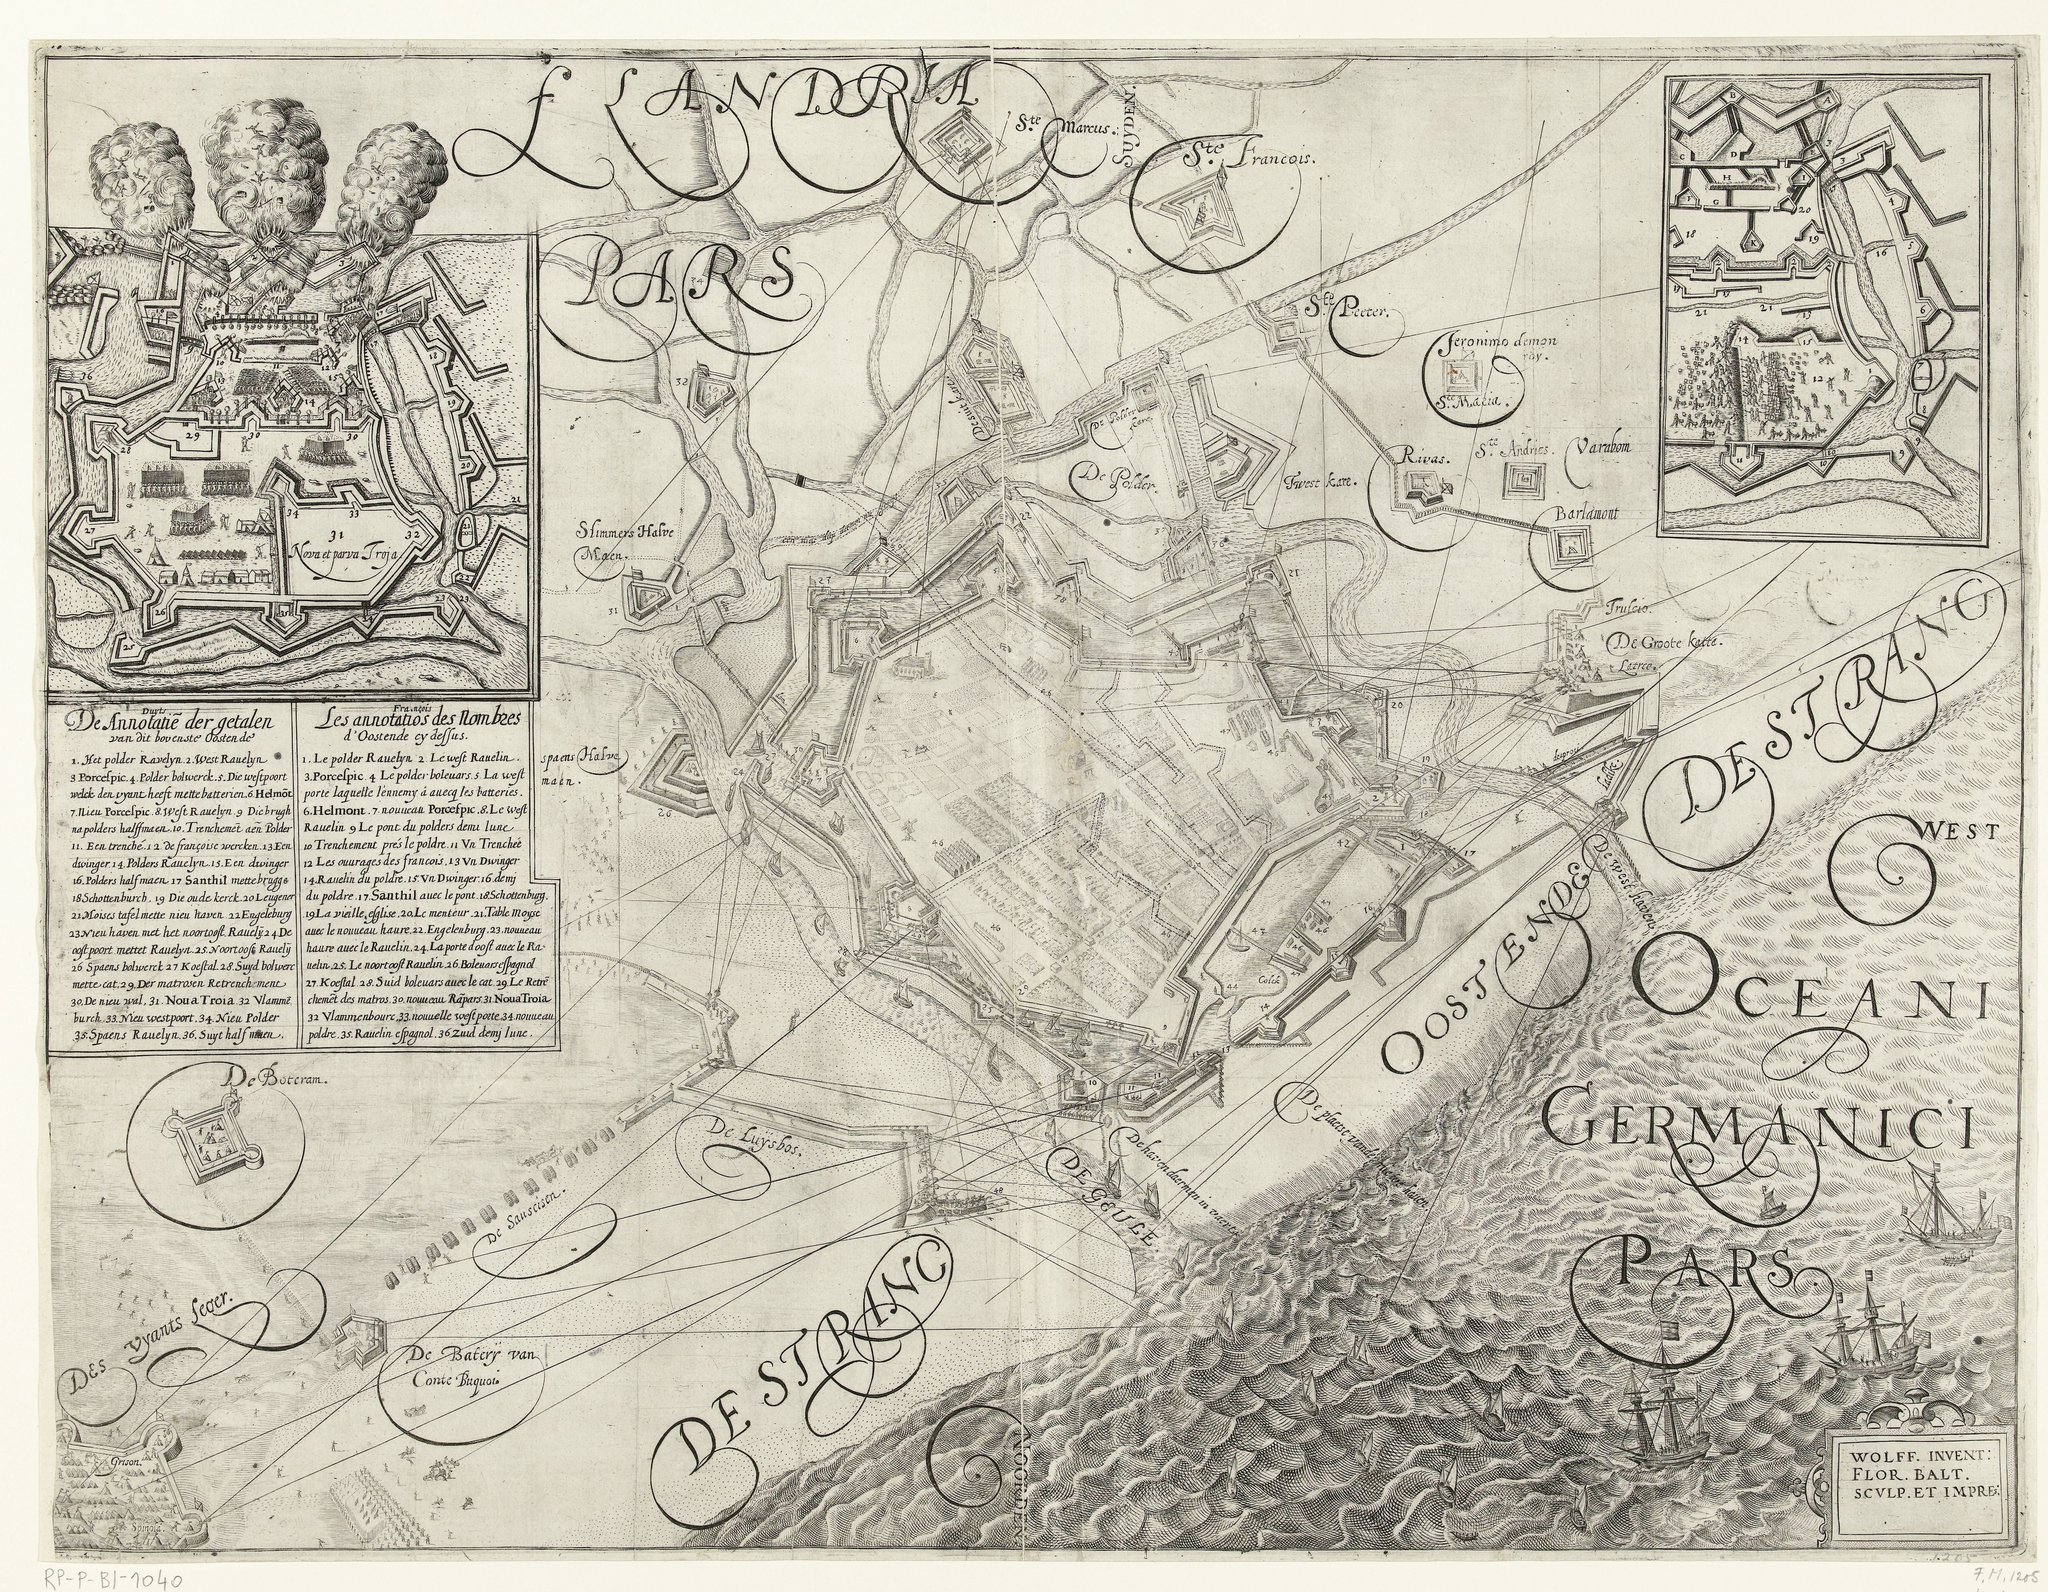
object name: print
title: Beleg van Oostende, 1604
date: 1604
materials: paper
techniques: engraving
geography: northern netherlands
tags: brussels, albrecht aartshertog van oostenrijk, siege, position war, maps of cities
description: Beleg van Oostende door het Spaanse leger onder Albrecht en later onder Spinola van 1601-1604. Plan van de stad met links en rechts de posities van de belegeraars in het jaar 1604. Linksboven een inzet met een plan van de verdedigingsweken, drie ontploffingen en een deel van de stad gemerkt als Nieuw Troje. Hierbij de legenda's 1-26 in het Nederlands en Frans. Rechtsboven een inzet met detailkaartje van de bolwerken.